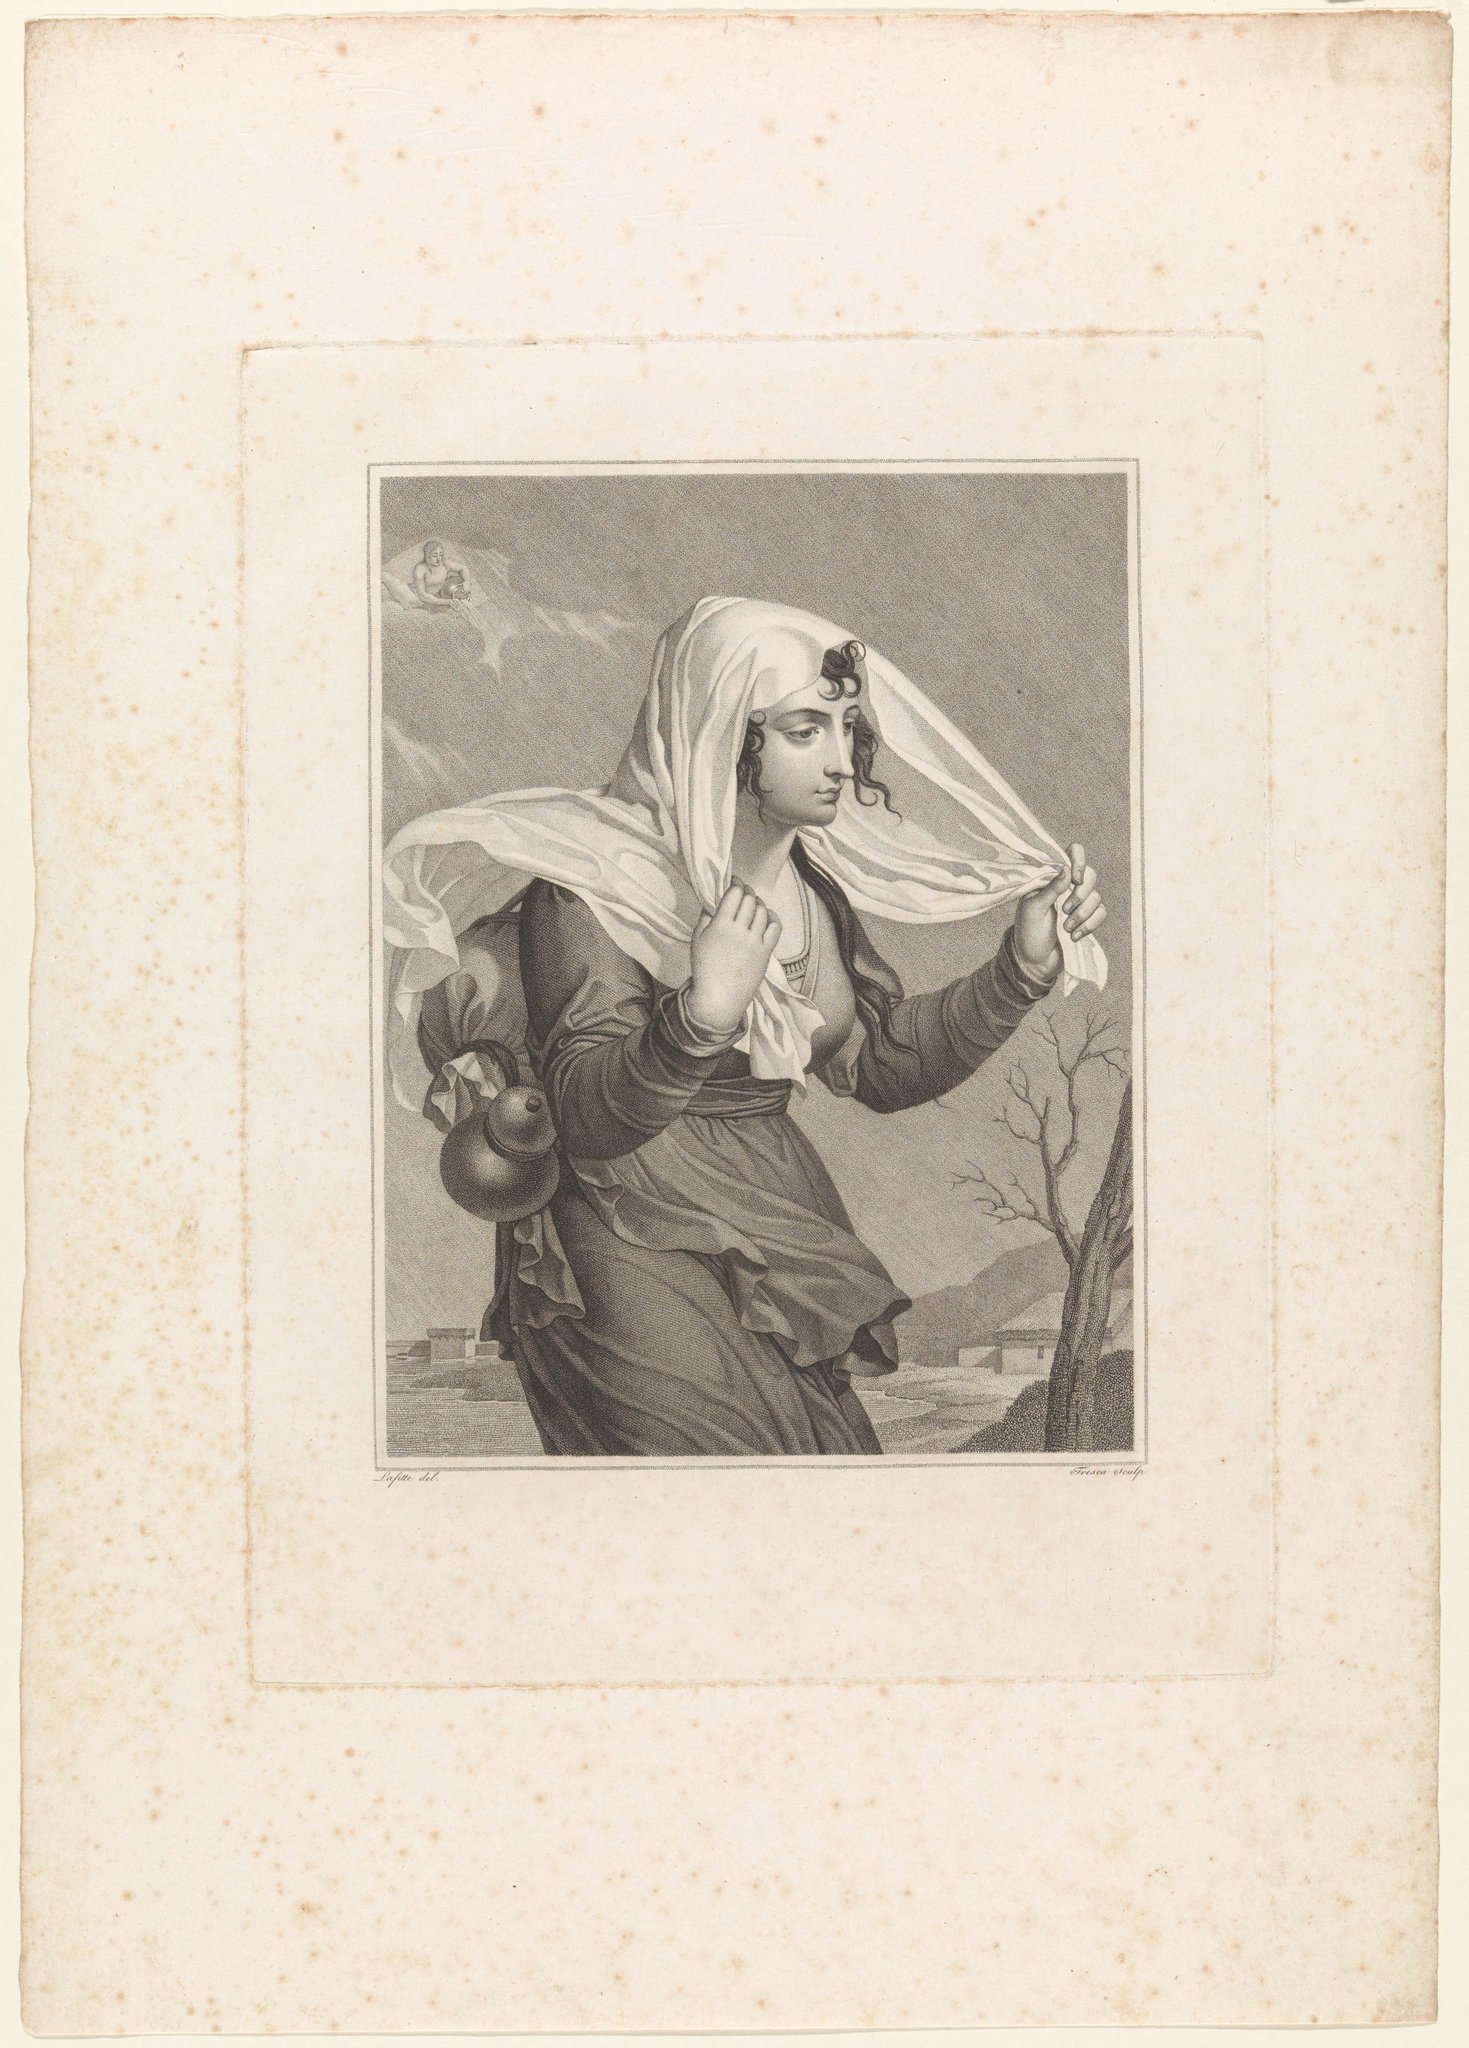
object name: print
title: De Twaalf Maanden van de Franse Republikeinse Kalender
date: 1792-1794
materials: paper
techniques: engraving, etching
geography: paris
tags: downpour, rain shower, february; 'febraro' (ripa), aquarius (zodiacal sign of january), january; 'gennaro' (ripa)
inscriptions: collector's mark: Lugt 2228, collector's mark: Lugt 2760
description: Maakt deel uit van een twaalfdelige serie met personificaties van de twaalf maanden volgens de Franse republikeinse kalender. De Franse republikeinse of revolutionaire kalender werd tussen 1793-1806 in revolutionair Frankrijk gebruikt. De jaartelling begon met de stichtingsdatum van de Republiek op 22 september 1792. De maanden waren anders ingedeeld en kregen nieuwe namen, gebaseerd op het klimaat, agricultuur en horticultuur.